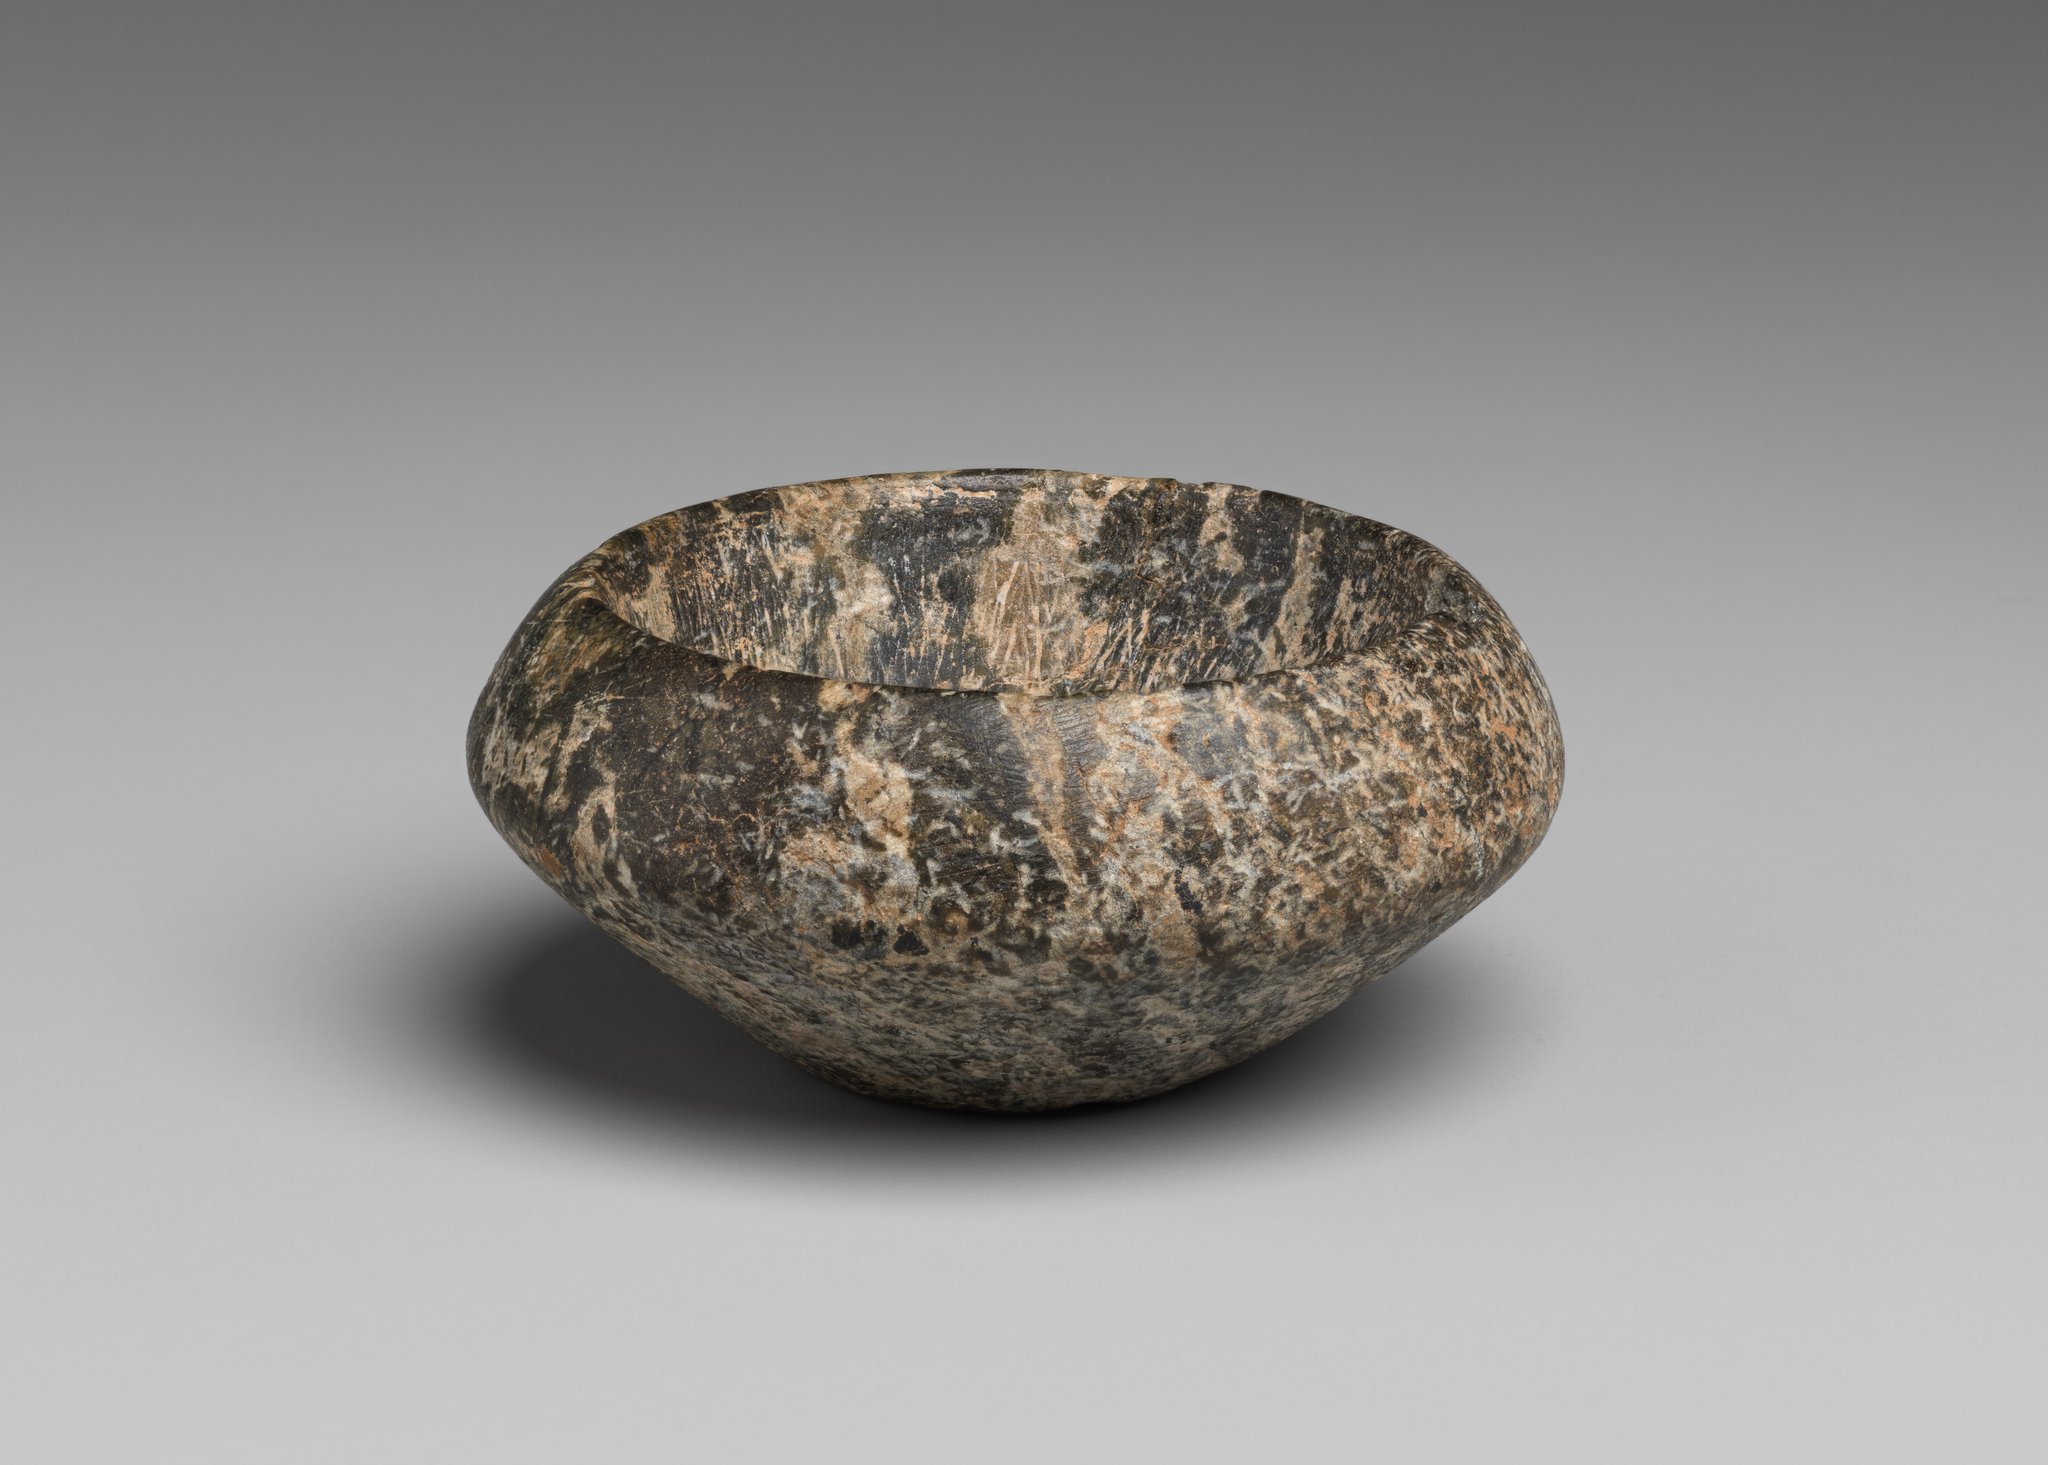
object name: bowl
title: Diorite carinated bowl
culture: minoan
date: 2000-1800 BCE